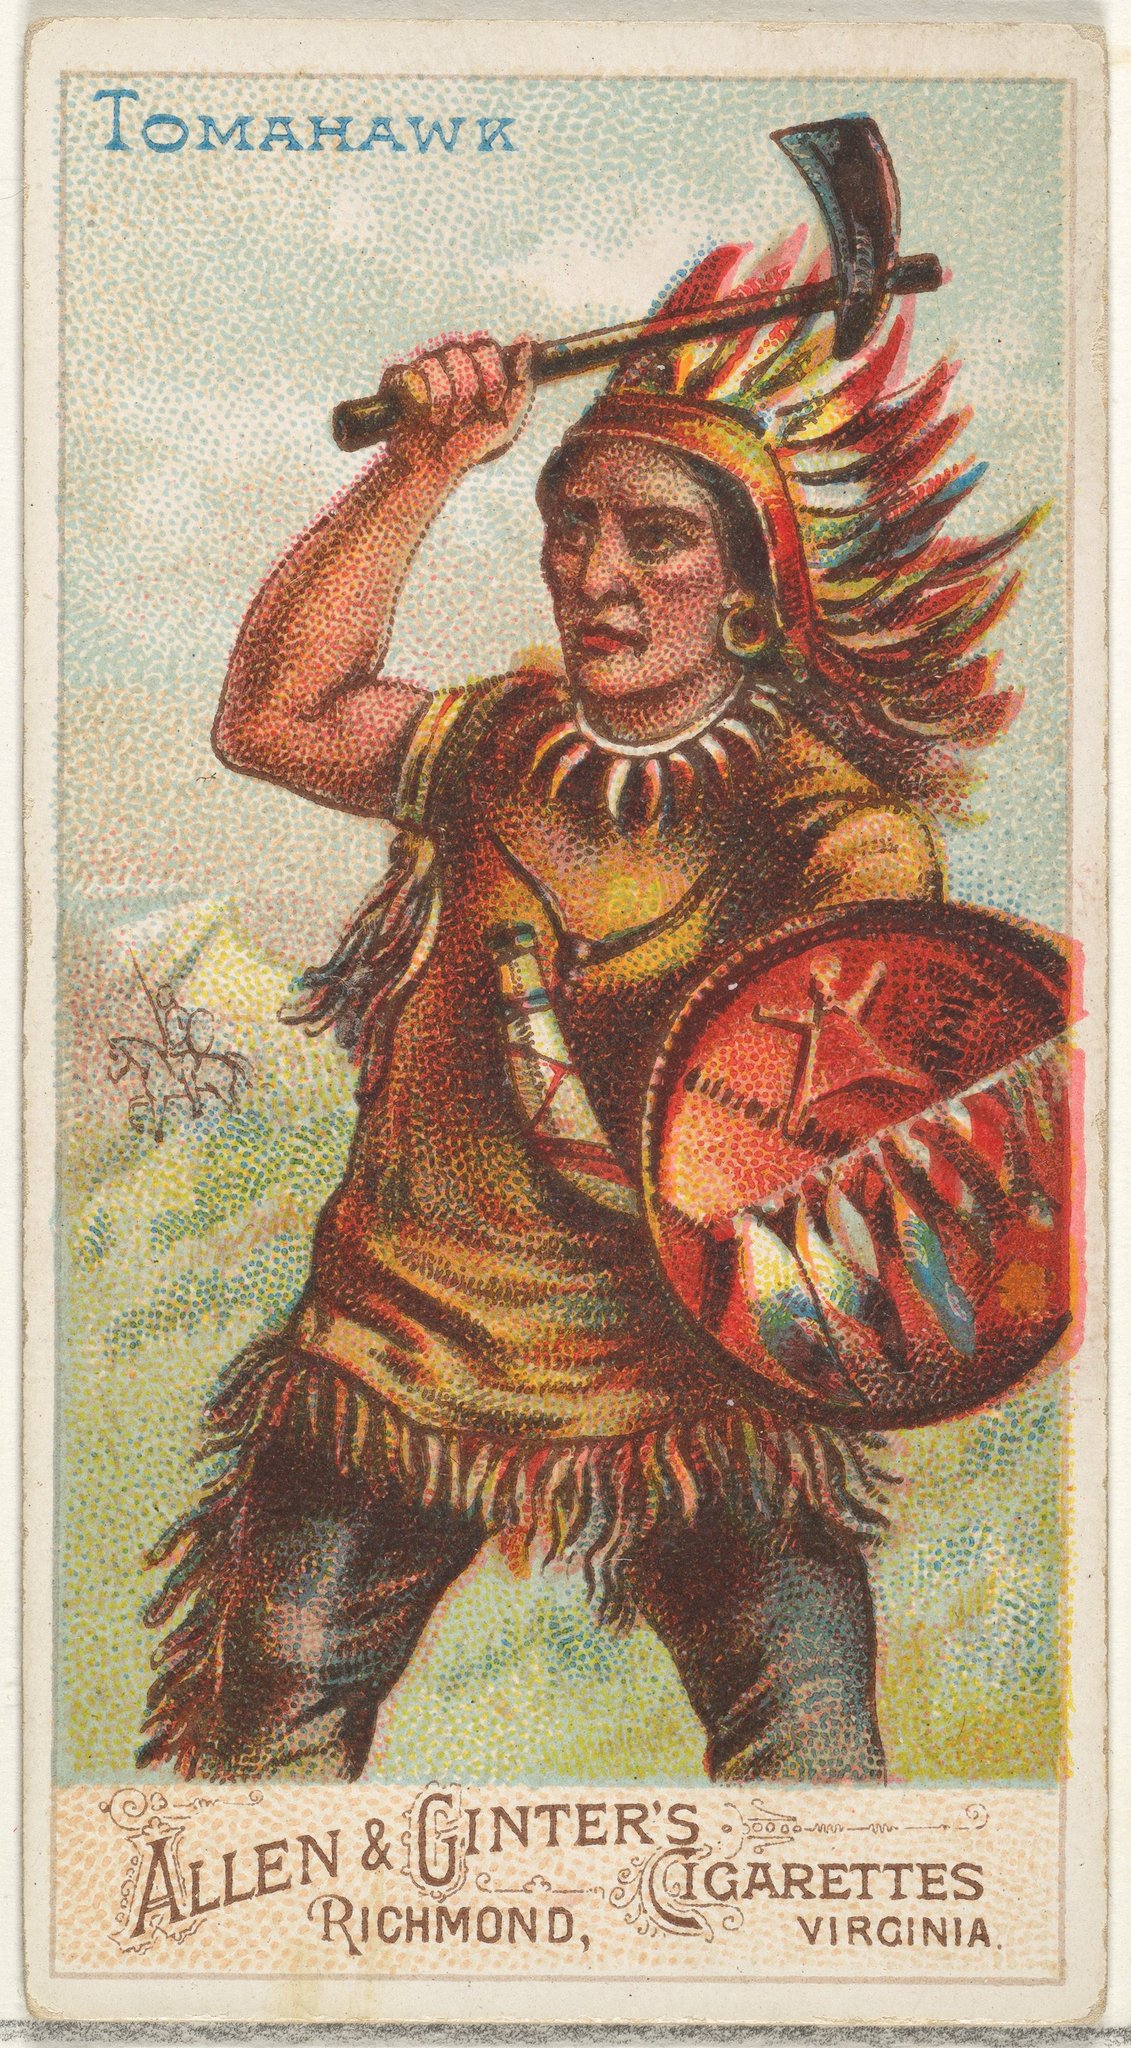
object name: print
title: Tomahawk, from the Arms of All Nations series (N3) for Allen & Ginter Cigarettes Brands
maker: allen & ginter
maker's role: publisher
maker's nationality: american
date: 1887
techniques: color lithograph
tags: men,axes